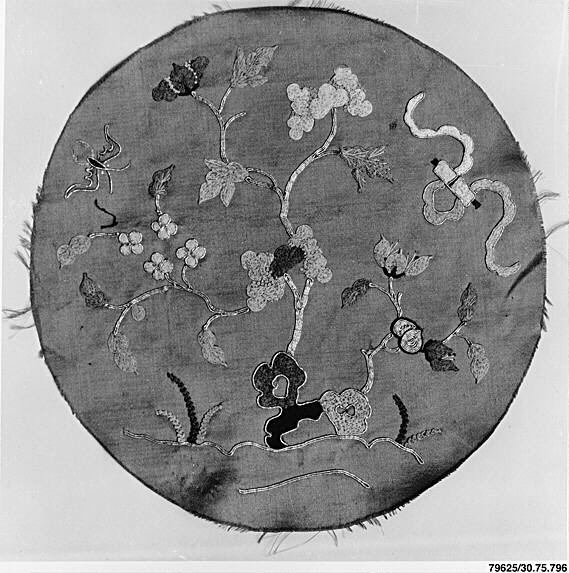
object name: medallion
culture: chinese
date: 1701-1800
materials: metal thread, silk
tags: leaves